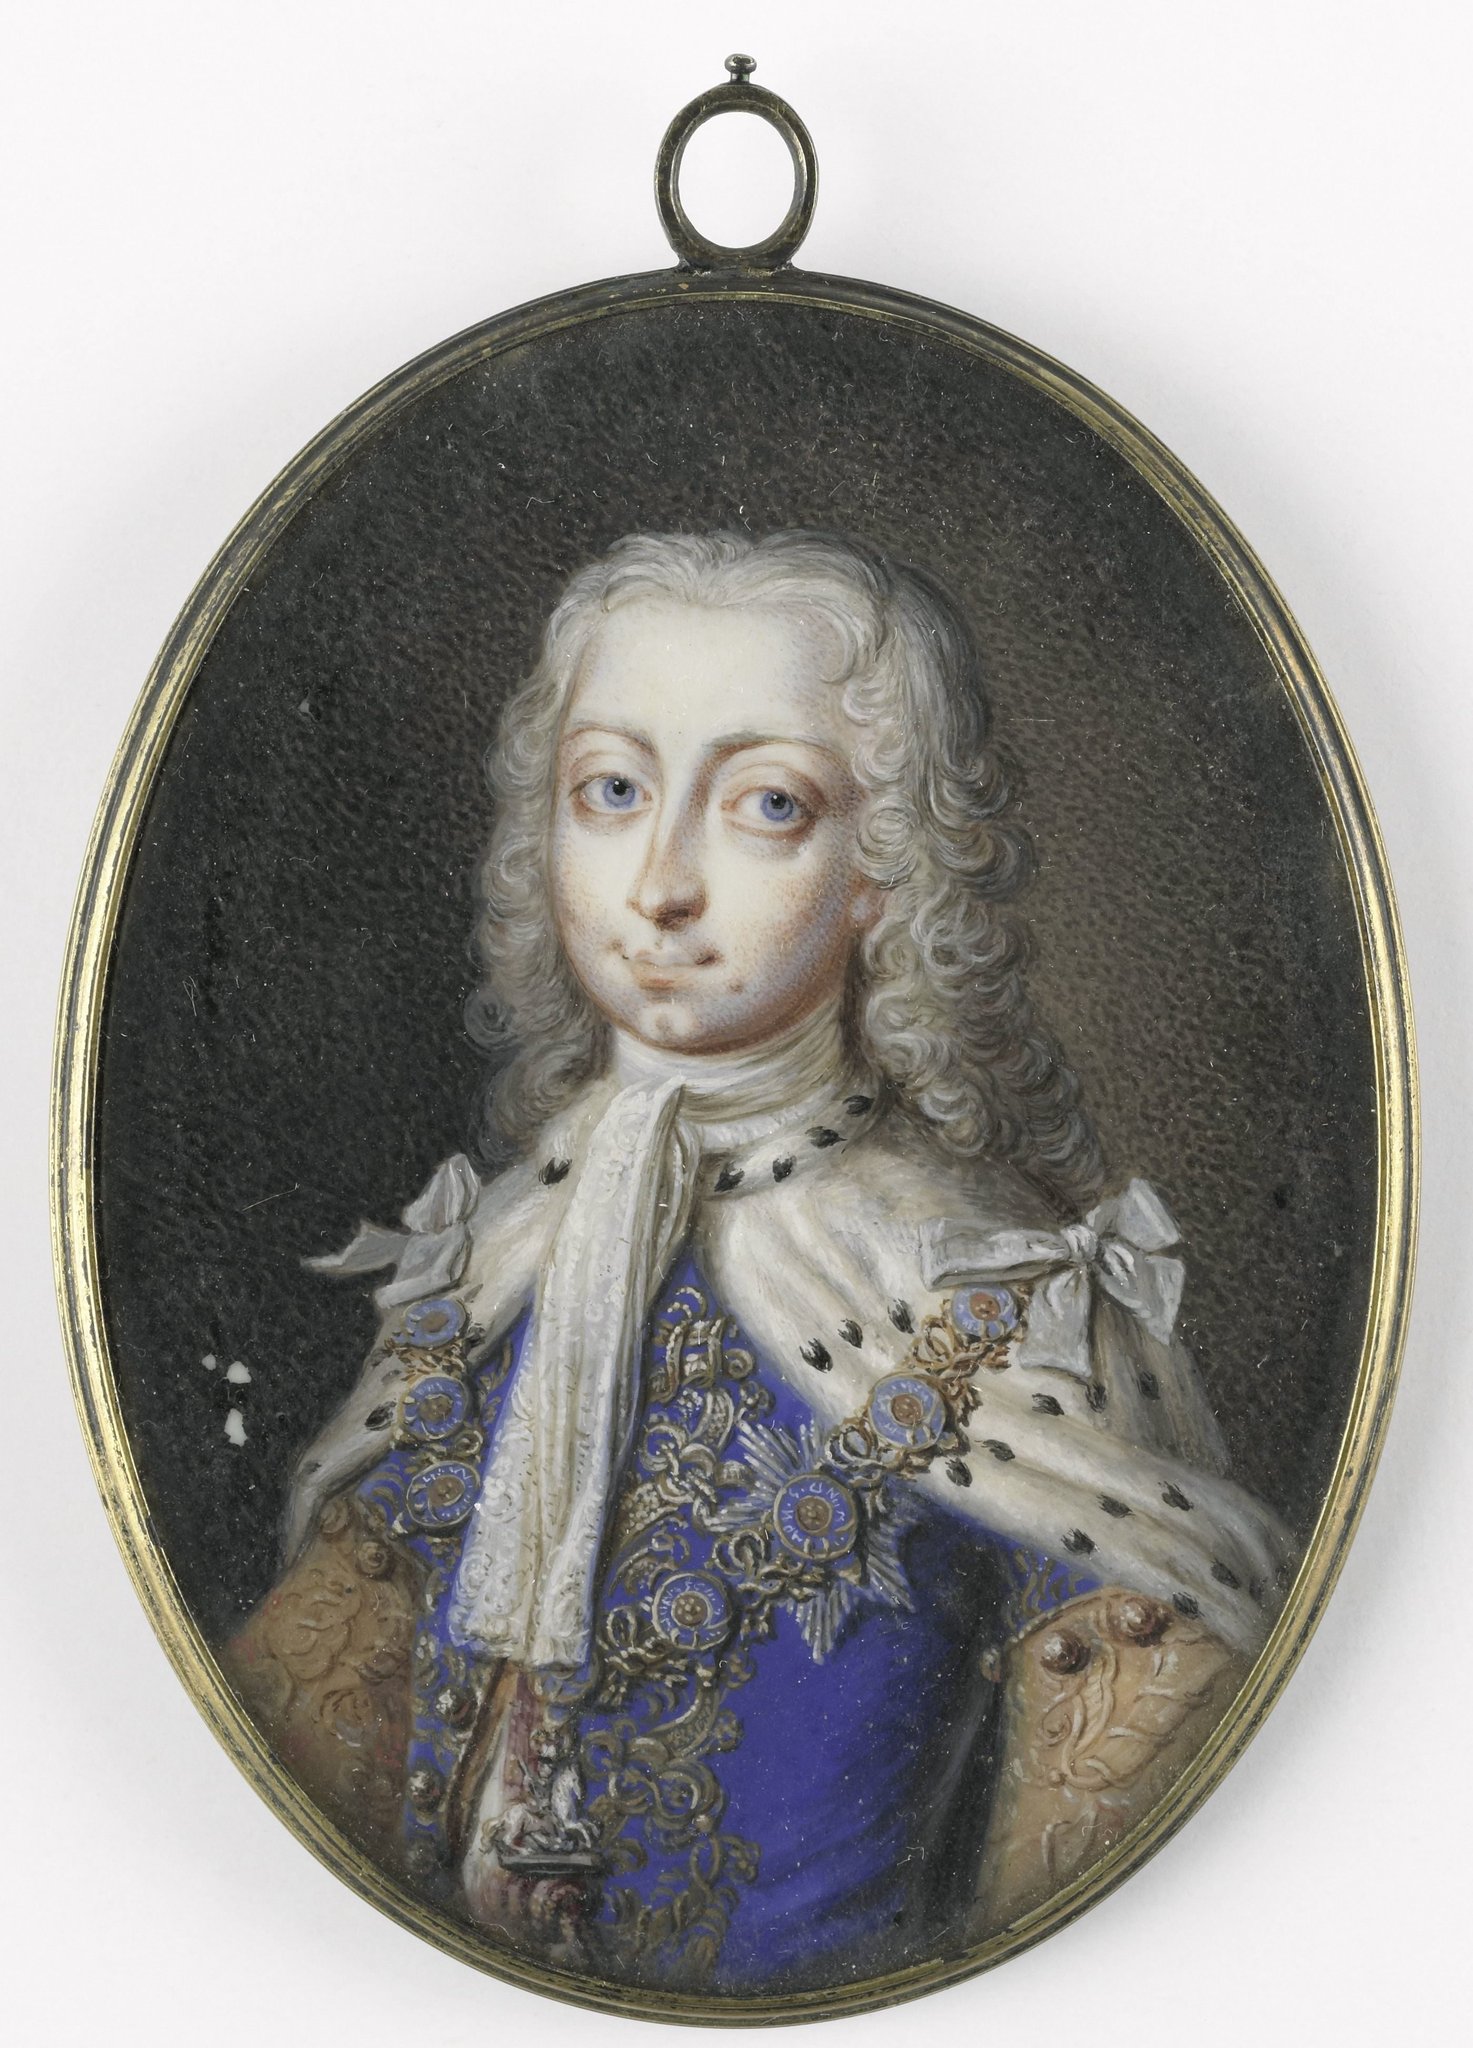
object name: painting, miniature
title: Frederick Louis (1707-51), prins van Wales. Zoon van koning George II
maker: Anonymous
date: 1735-1740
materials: glass, ivory, metal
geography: england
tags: london, frederik (prins van wales)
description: Frederick Louis, Prince of Wales (1707 - 51). English school. After an original by Philip Mercier. Ivory, c. 1735 - 40.